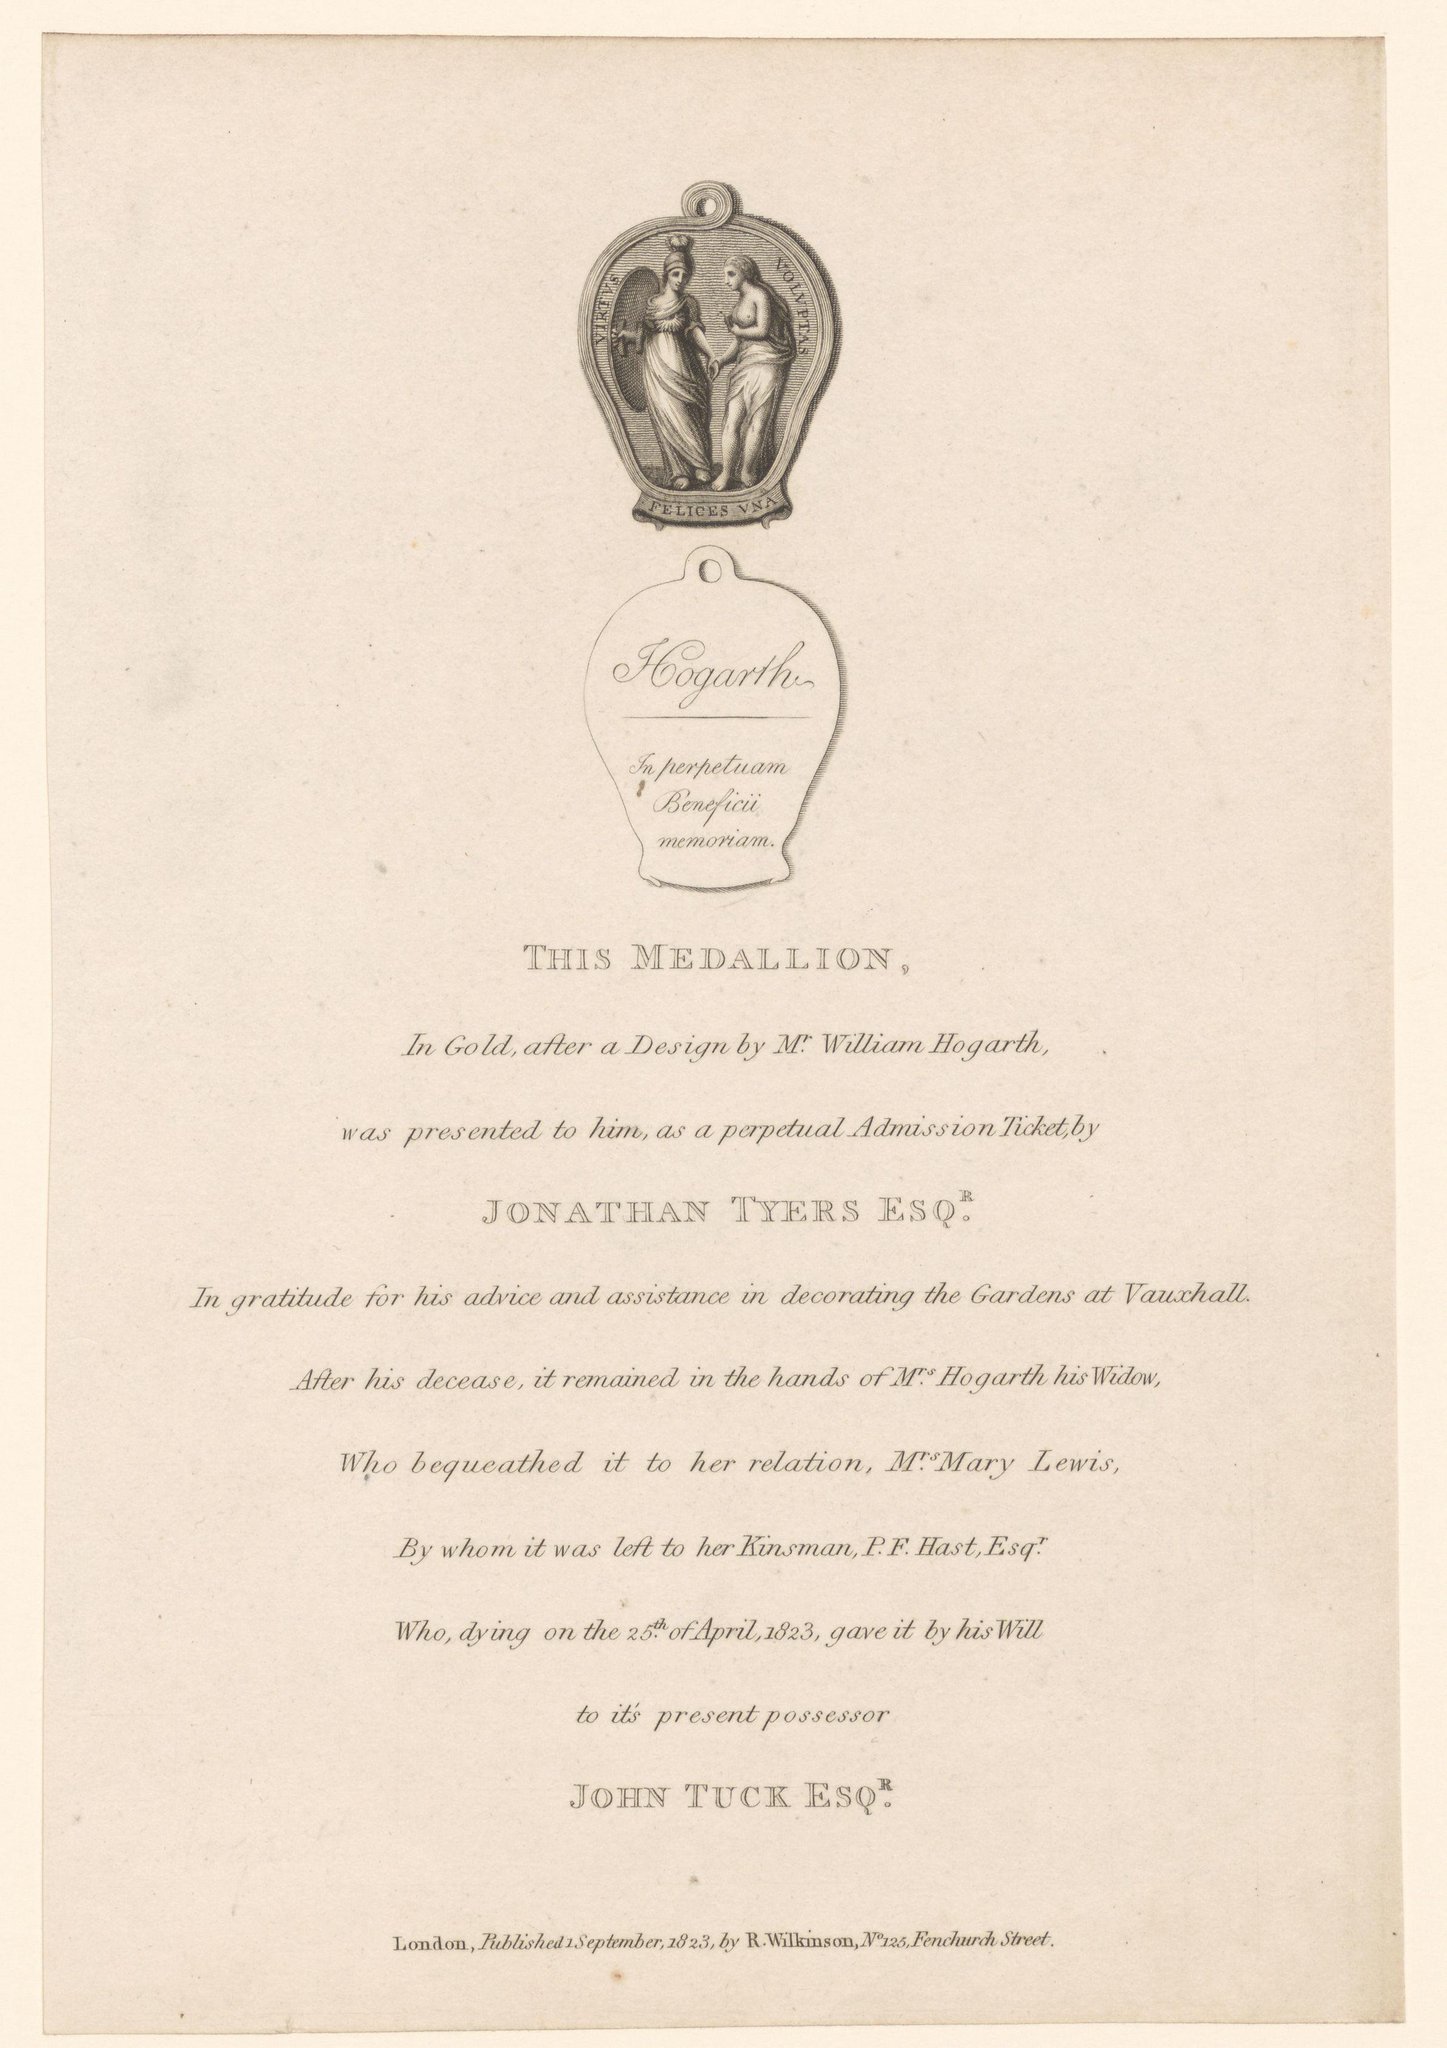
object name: print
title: Medaillon met personificaties van Moed (Virtus) en Wellust (Voluptas)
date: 1823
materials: paper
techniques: engraving, etching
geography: london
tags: medal (considered as a piece of sculpture, regardless of its specific function)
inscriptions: collector's mark: Lugt 2228